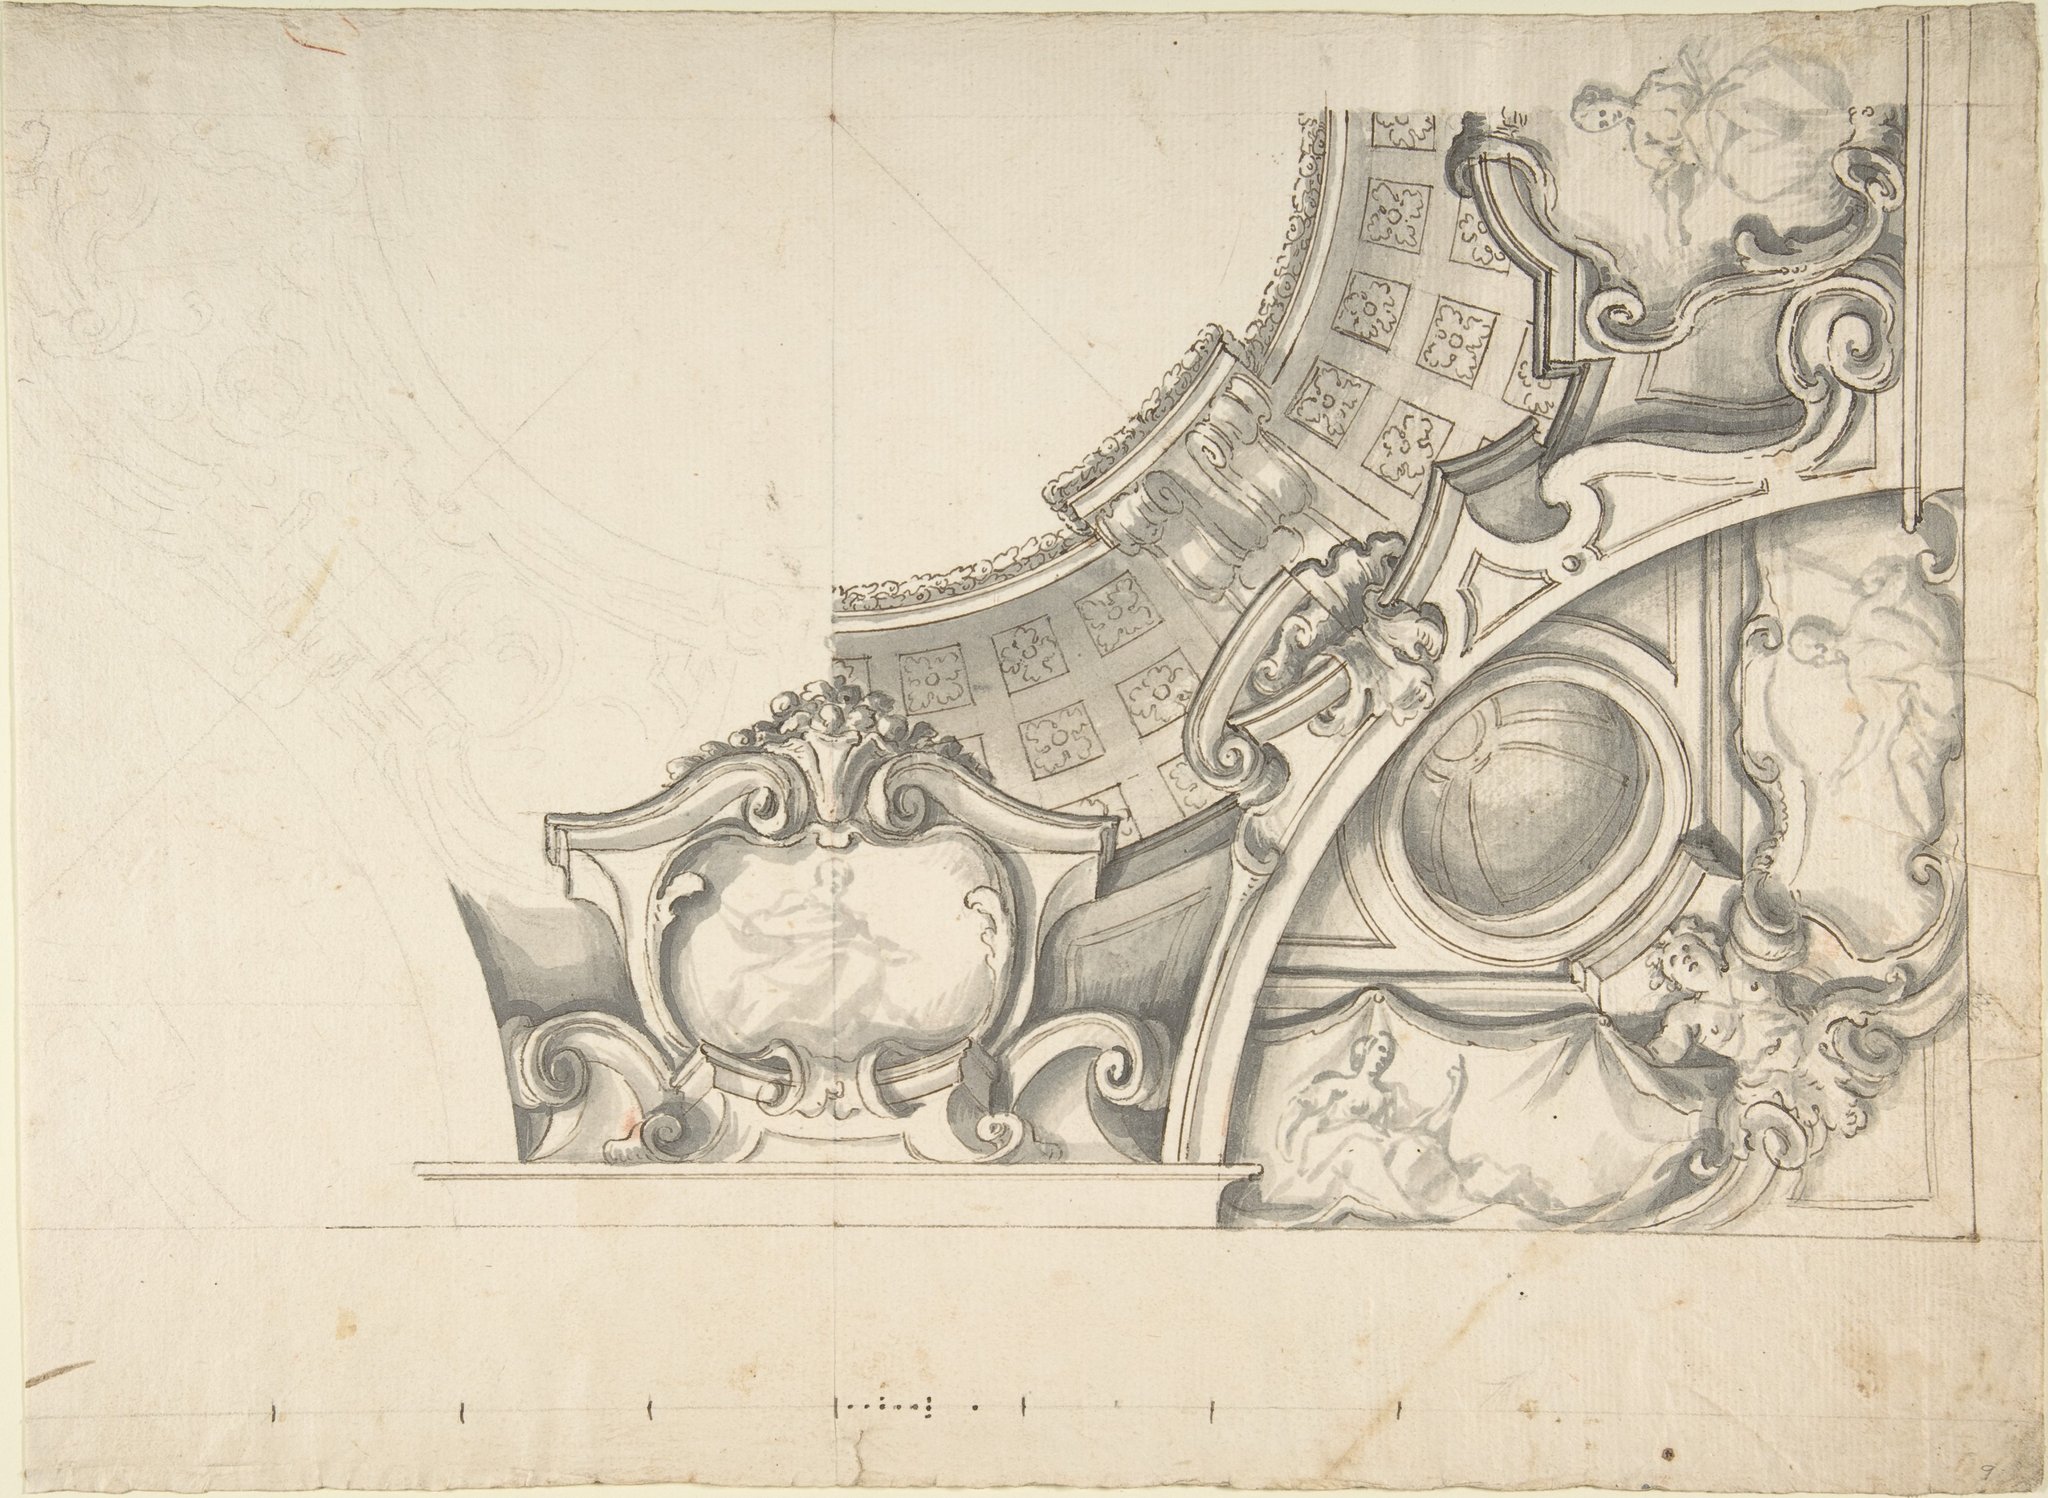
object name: drawing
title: Design for a Ceiling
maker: anonymous, italian, piedmontese, 18th century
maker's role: artist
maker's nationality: italian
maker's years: 1700-1800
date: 1700-1780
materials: ink, drawing material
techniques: brush, pen, wash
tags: architecture,ceilings